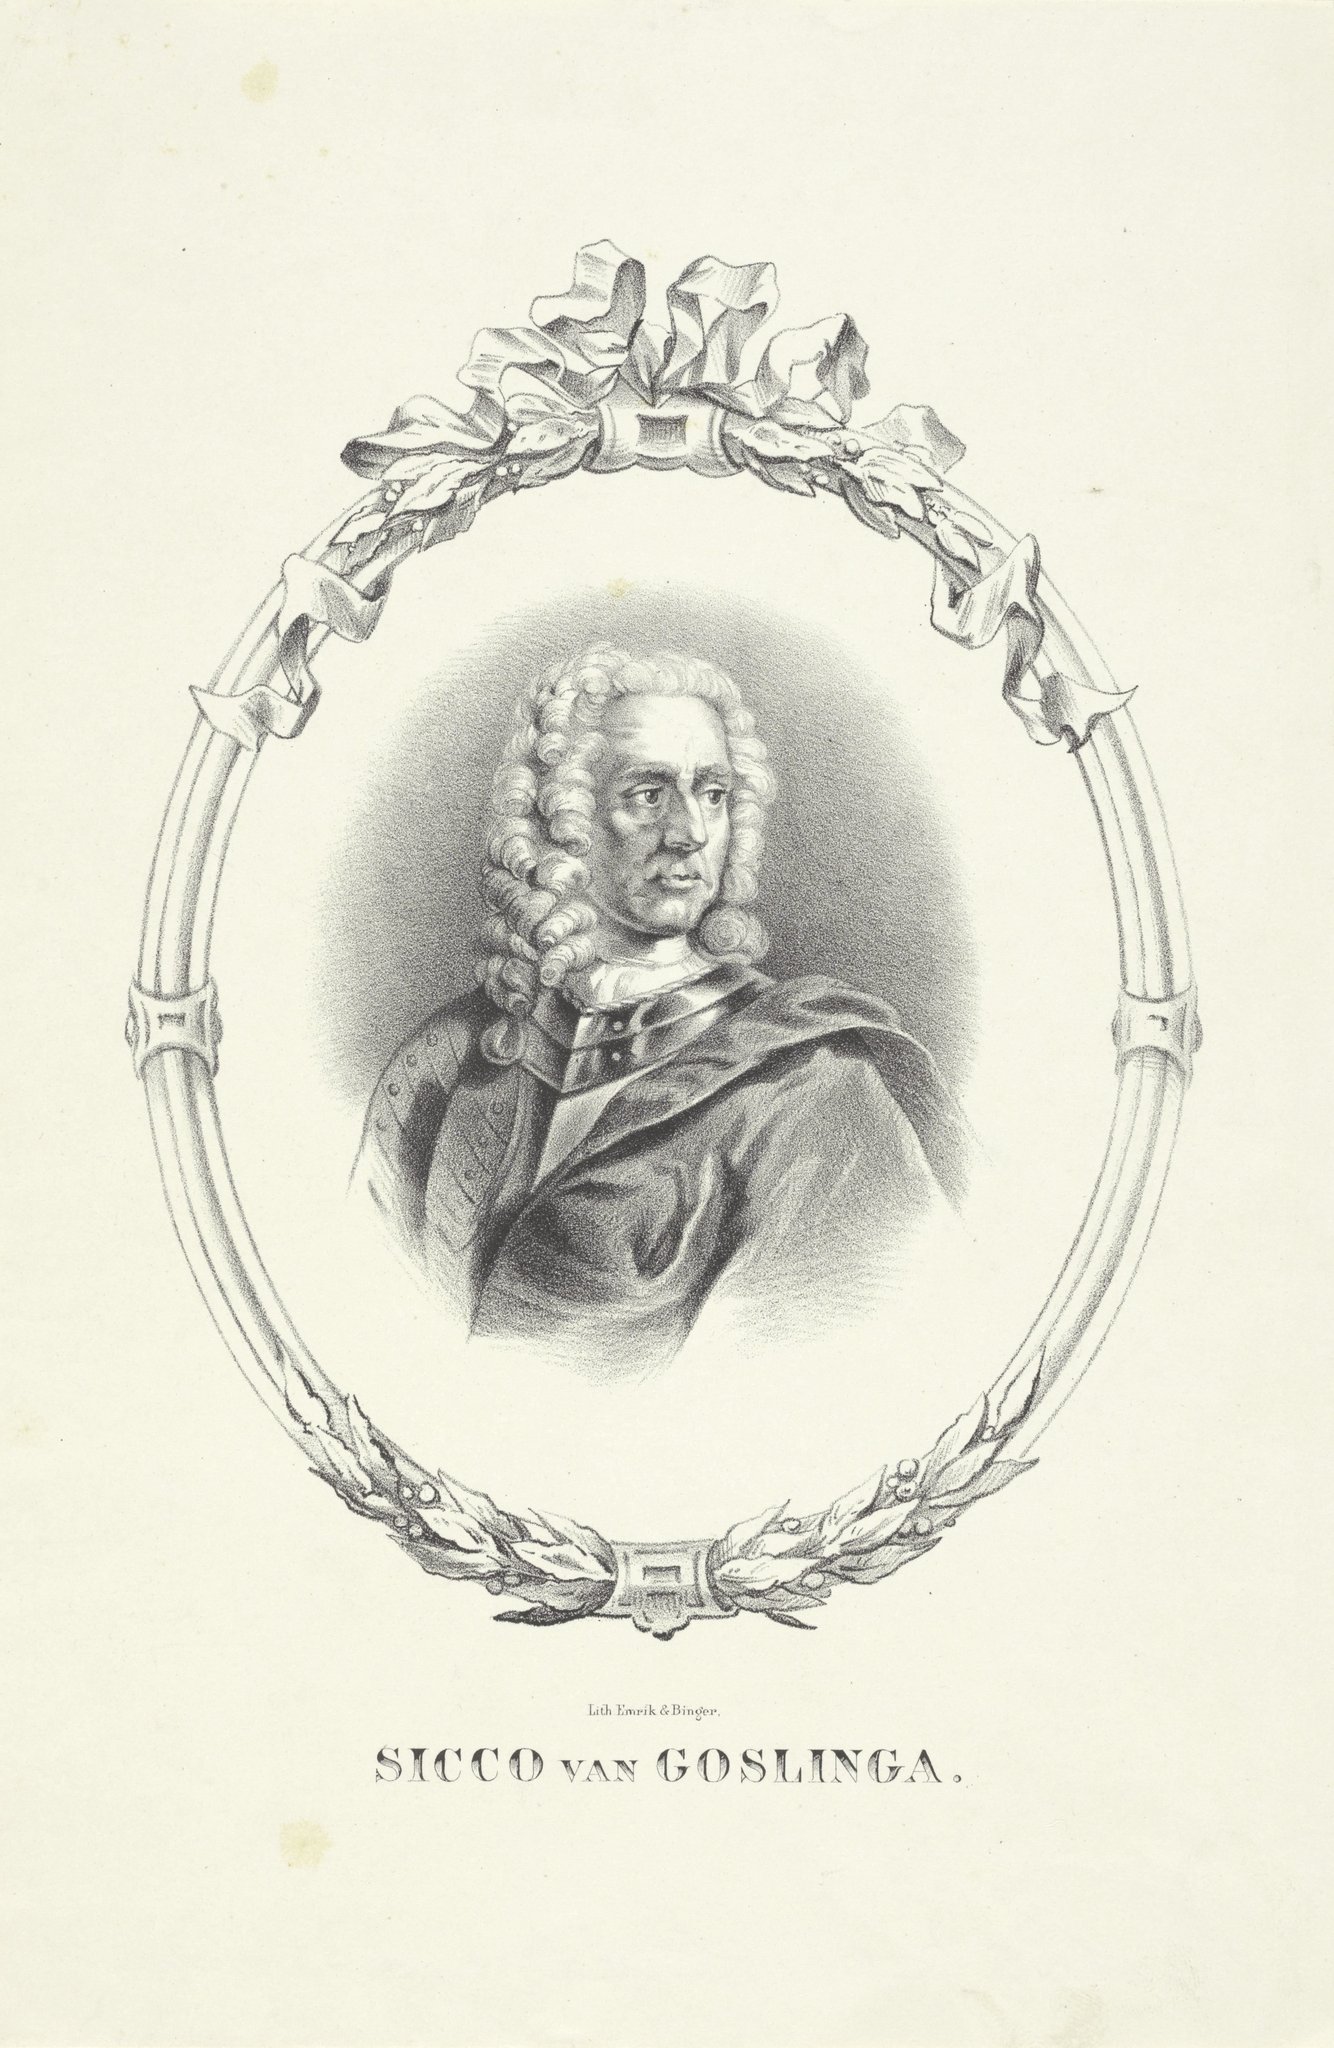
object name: print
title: Portret van Sicco van Goslinga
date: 1857-1910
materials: paper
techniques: lithograph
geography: haarlem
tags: armour, trees: laurel, historical persons (+ (full) bust portrait)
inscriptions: collector's mark: Lugt 2228, inscription: ‘Uit: Arend's Geschiedenis d. Vaderlands deel IV stuk II. Afl. 30/31.’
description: De geportretteerde kijkt naar rechts over zijn schouder. Hij draagt een harnas en een lange pruik met krullen. Over zijn linkerschouder hangt een mantel. Het portret is afgebeeld in een ovalen lijst met een strik en lauwertakken. Onder het portret zijn naam.